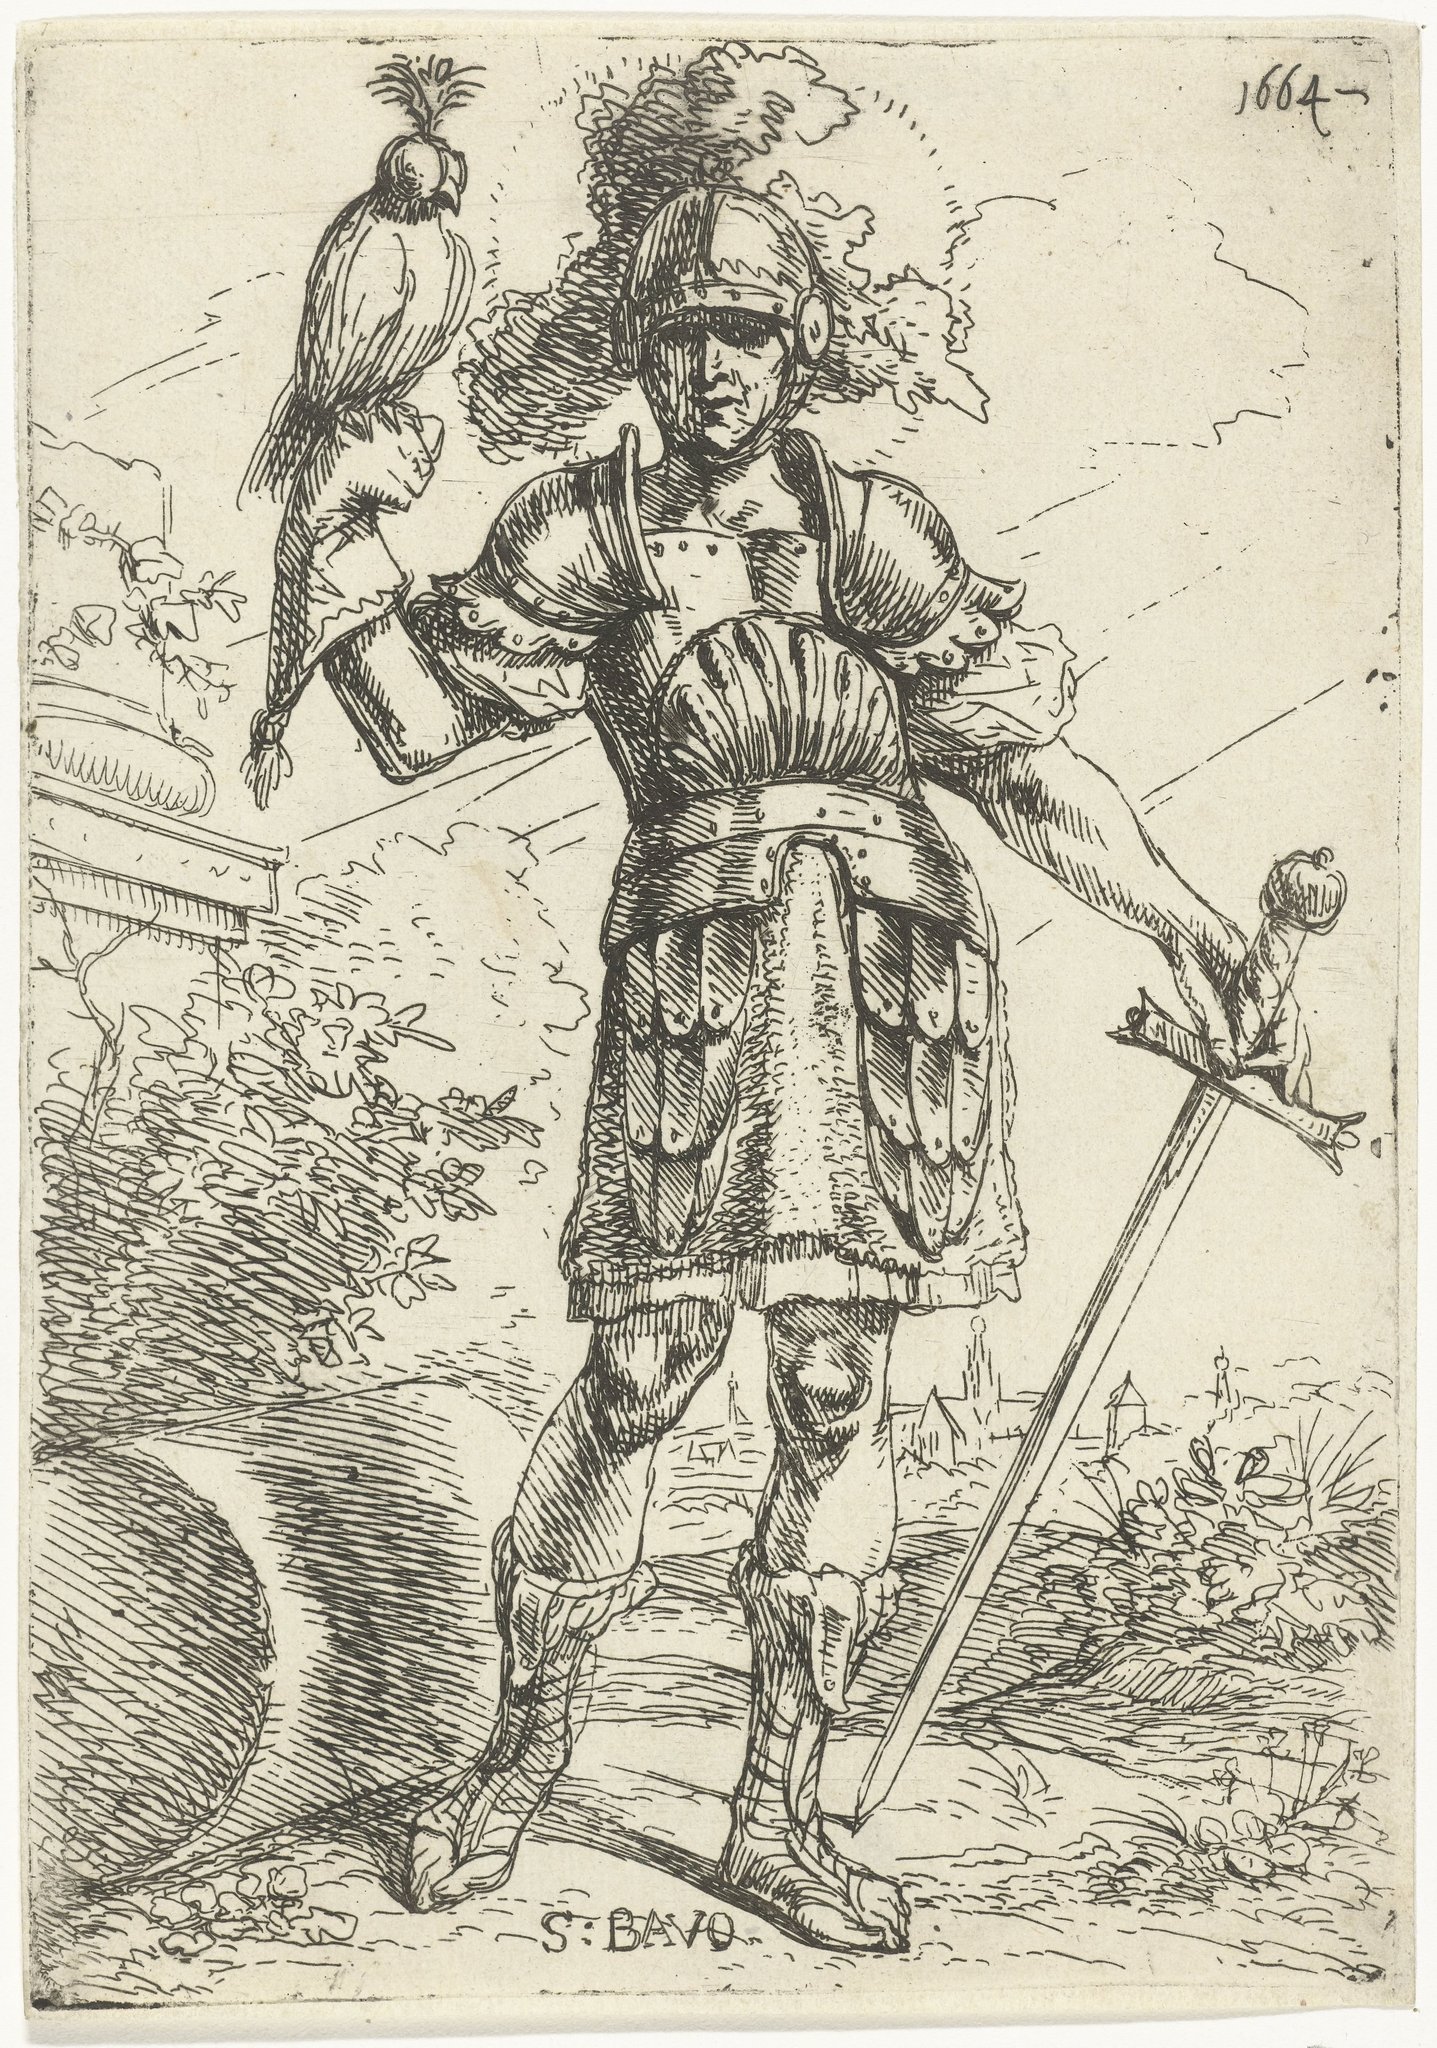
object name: print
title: H. Bavo met valk op zijn hand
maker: leendert van der cooghen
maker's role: draughtsman, print maker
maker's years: 1632-1681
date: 1664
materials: paper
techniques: etching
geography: haarlem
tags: the hermit bavo of ghent; possible attributes: falcon, hollow tree, purse, stone, sword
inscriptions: collector's mark: Lugt 1904, collector's mark: Lugt 2760, collector's mark: Lugt 2228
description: De heilige Bavo gekleed als Romeinse soldaat met een valk op zijn hand. In de andere hand een zwaard. Links Romeinse ruïnes.